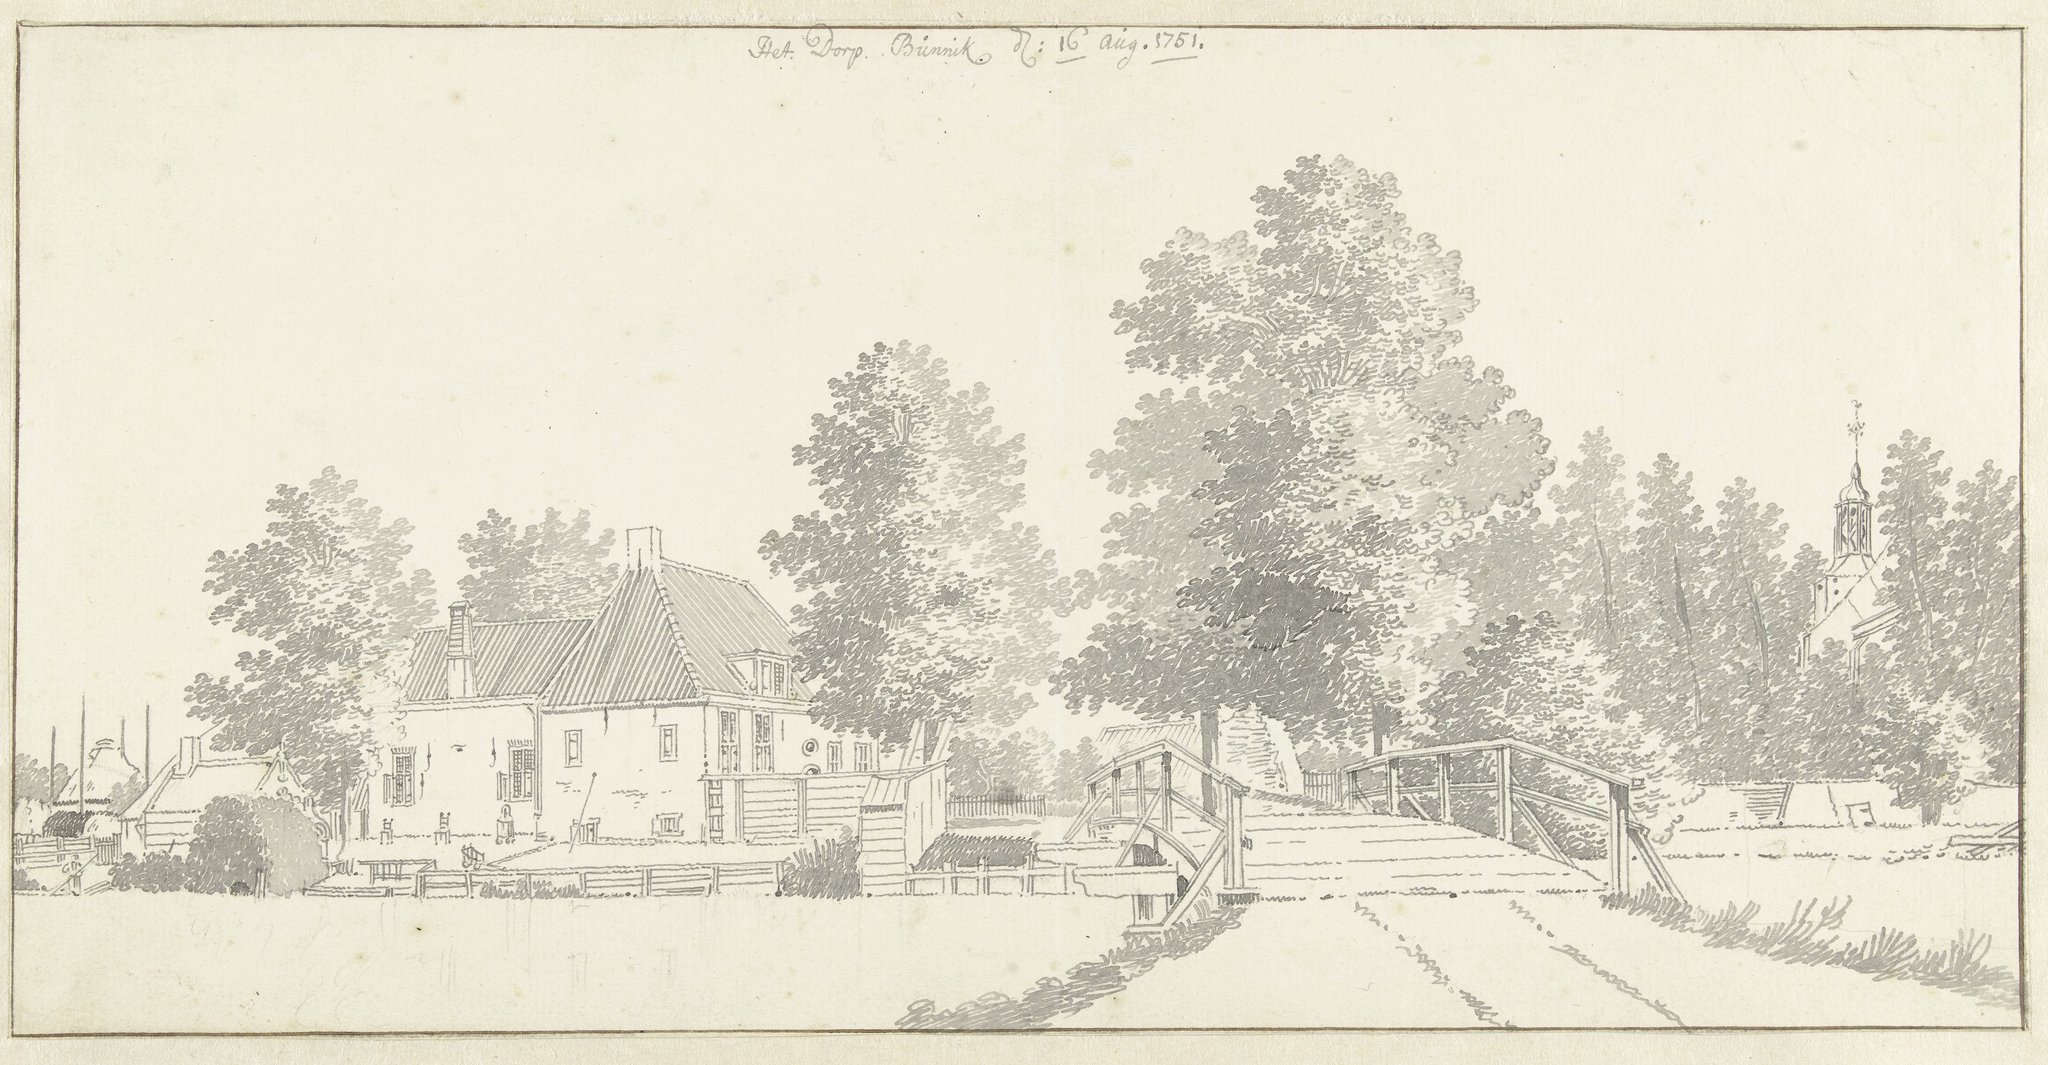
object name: drawing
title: Gezicht te Bunnik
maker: jan de beijer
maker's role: draughtsman, print maker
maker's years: 1703-1780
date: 1751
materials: ink, paper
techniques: pen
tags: bunnik